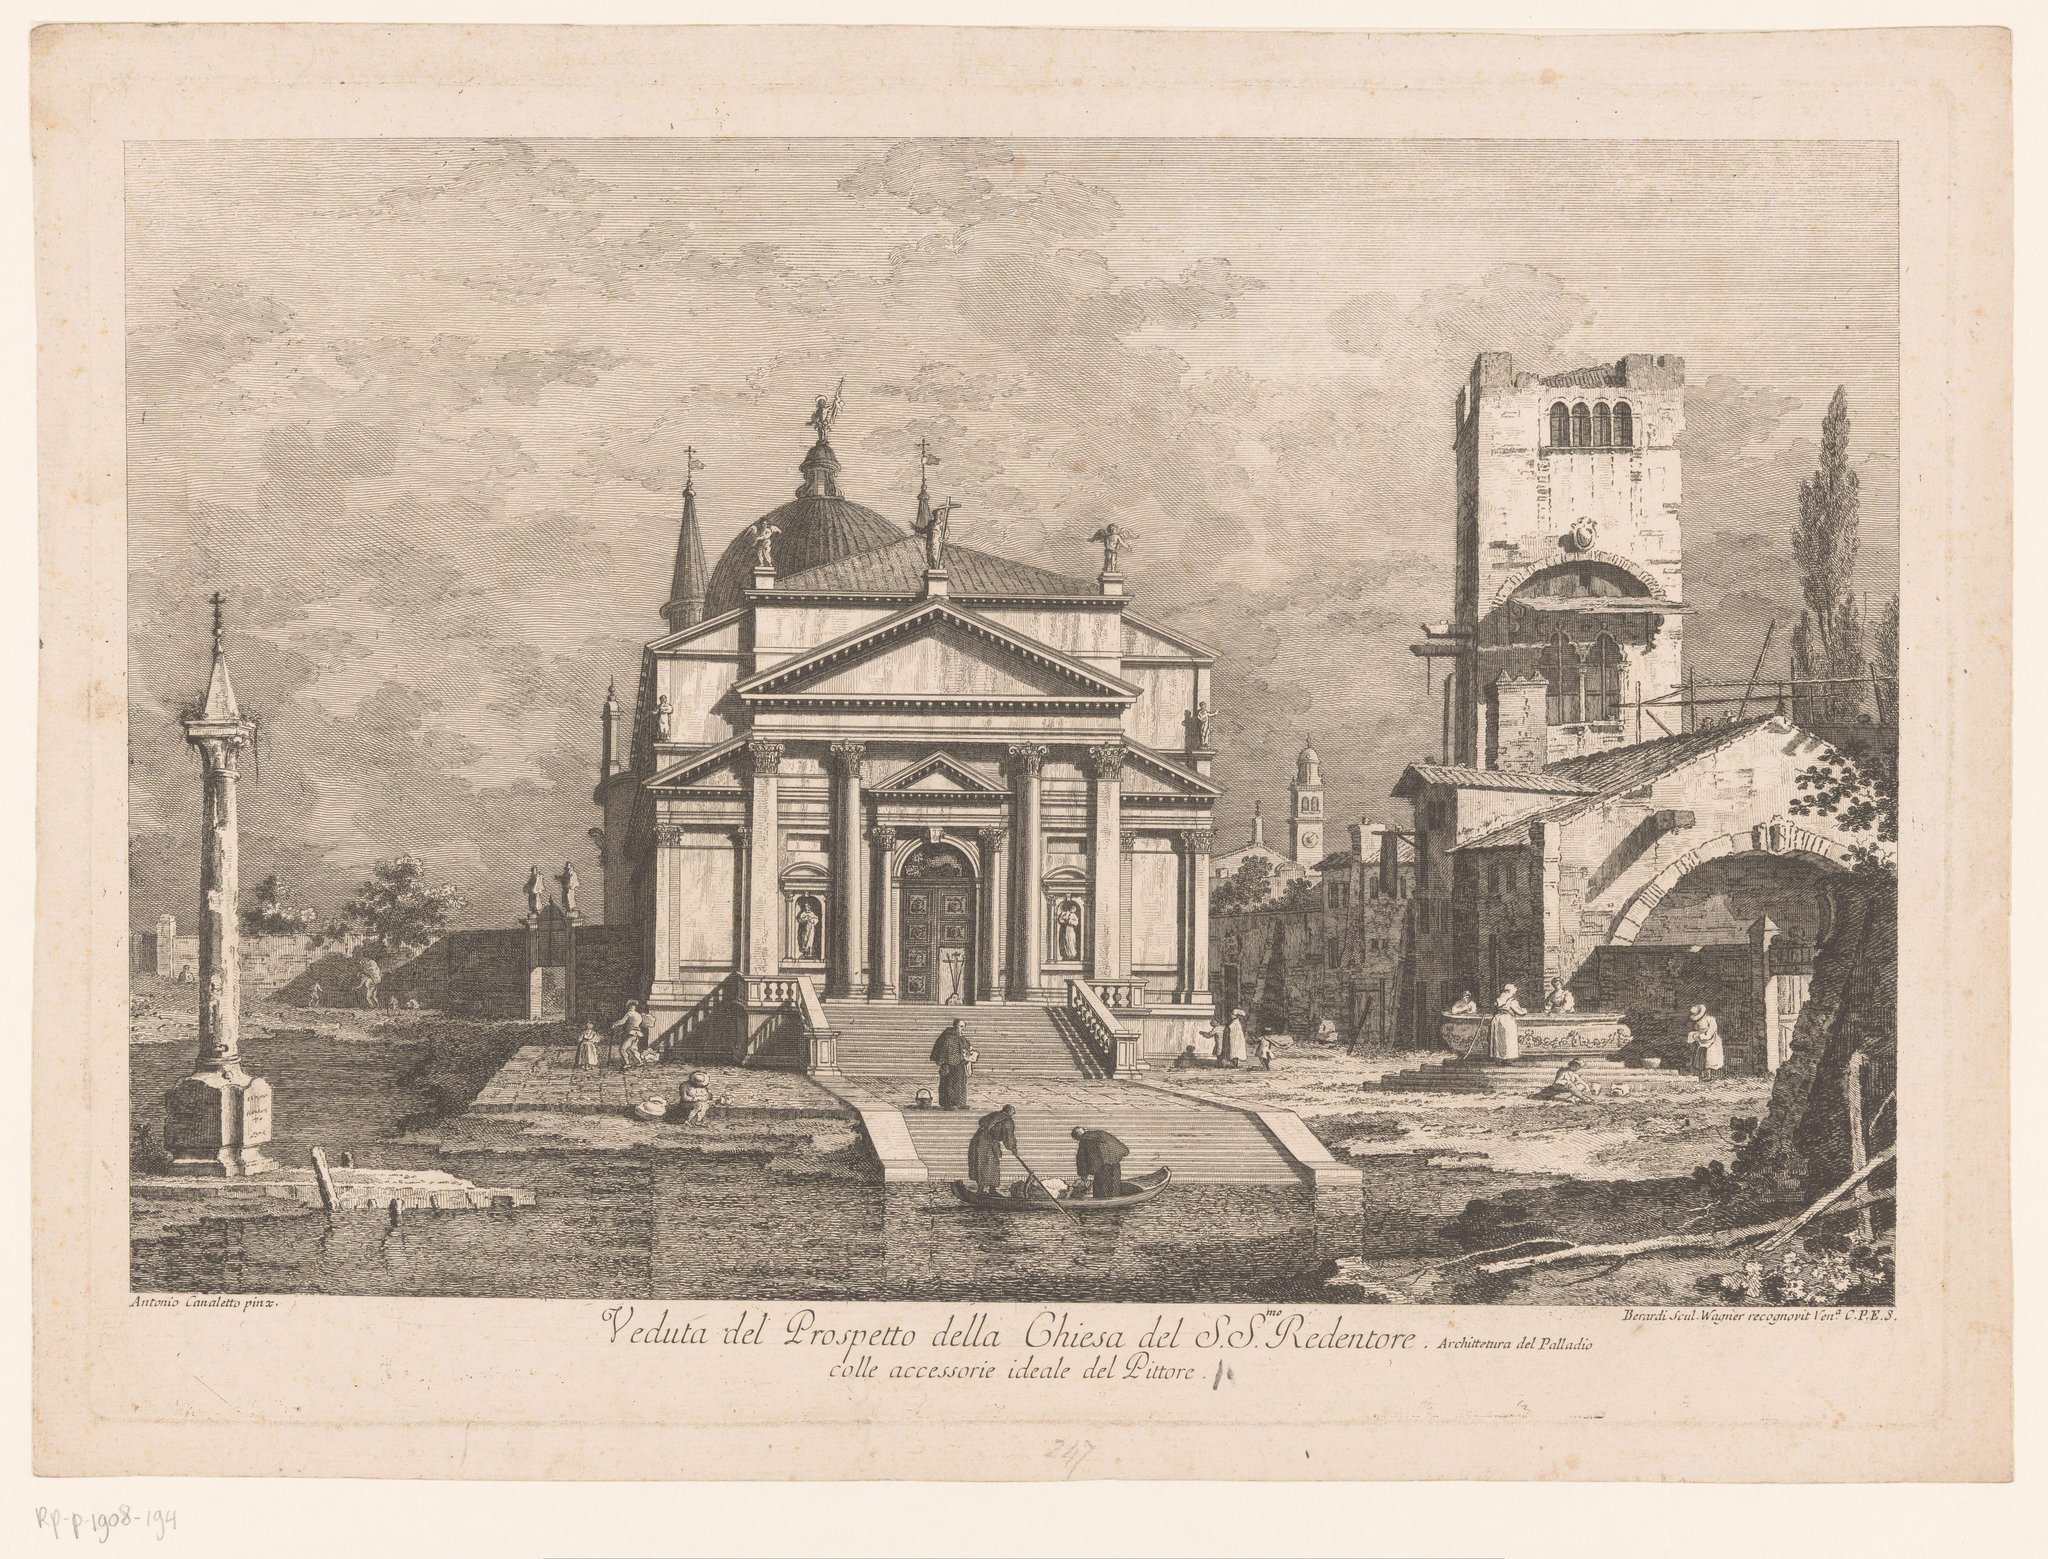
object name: print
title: Gezichten op Venetië naar ontwerpen van Canaletto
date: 1742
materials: paper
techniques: etching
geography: venice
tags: andrea palladio, church (exterior), roman catholic church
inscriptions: collector's mark: Lugt 2228